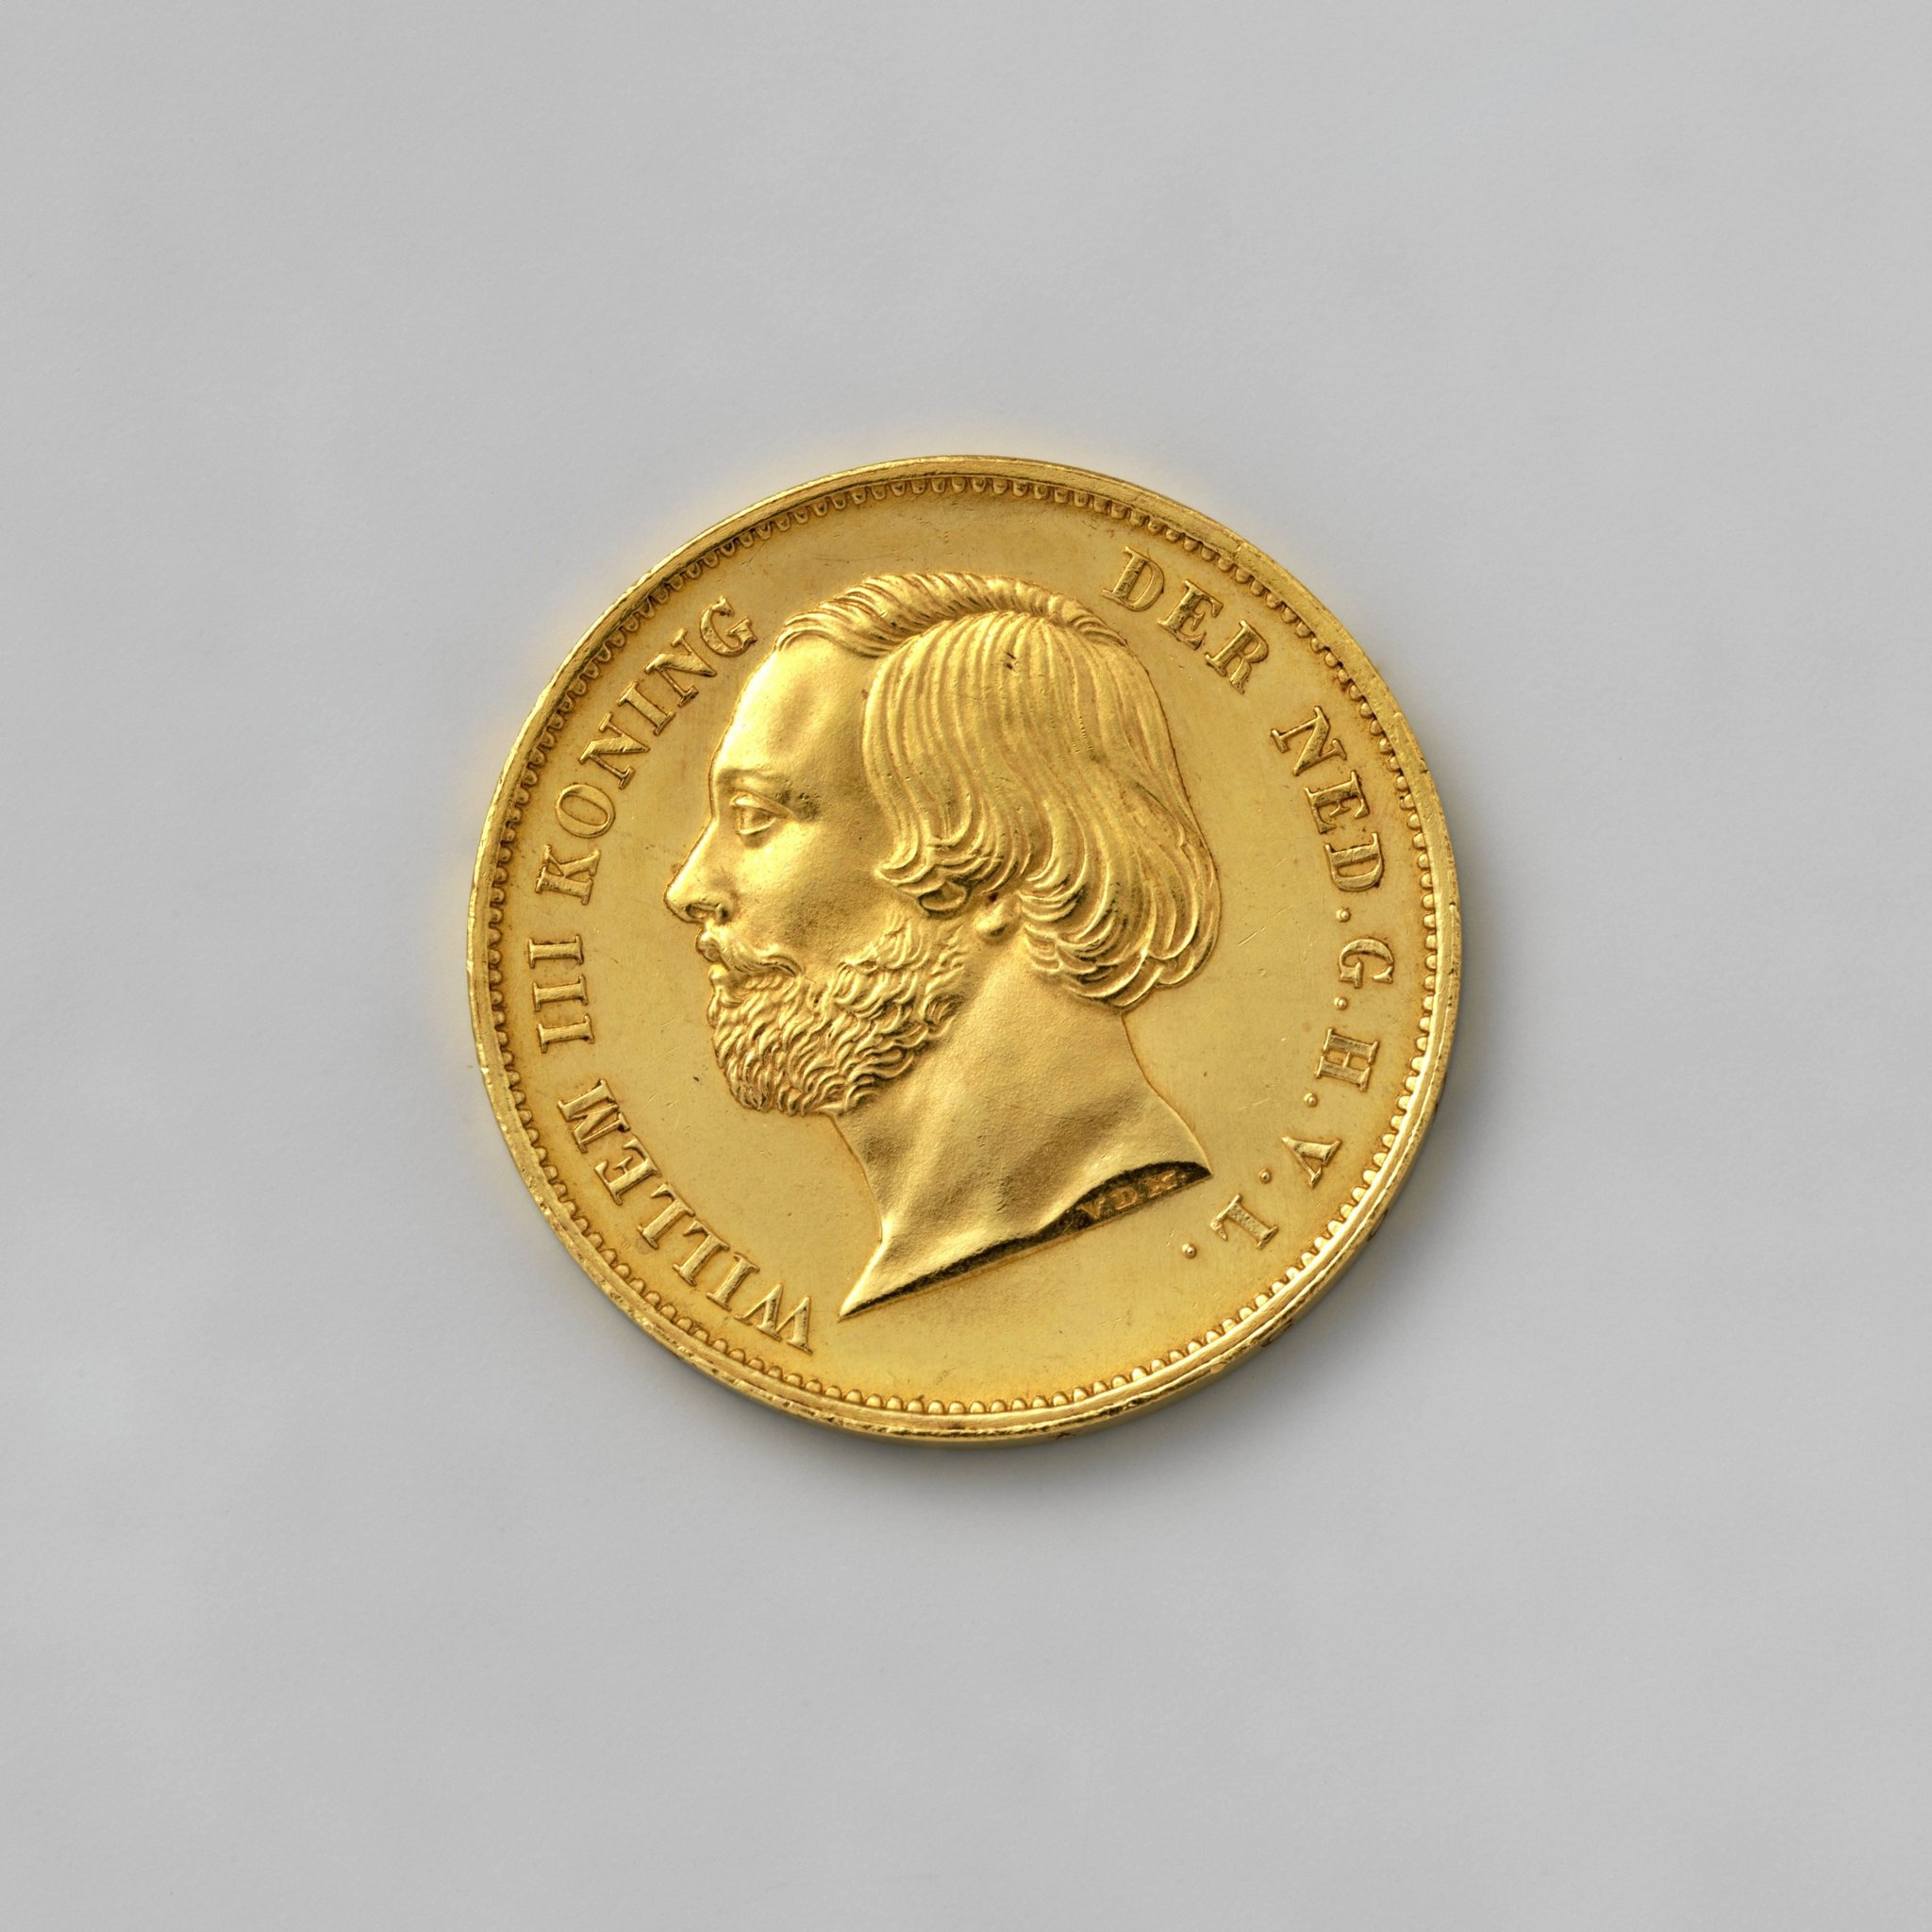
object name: dubbele negotiepenning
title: Nederlandse dubbele negotiepenning of dubbele Willem, 1851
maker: willem iii (koning der nederlanden)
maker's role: koning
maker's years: 1817-1890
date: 1851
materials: gold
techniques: striking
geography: utrecht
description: Gouden negotiepenning. Voorzijde: borstbeeld naar links. Keerzijde: tussen twee samengebonden eiketakken gekroond rijkswapenschild. Omschrift: Jaartal, boven kroon, gewicht- en gehalte-aanduiding. Randschrift.